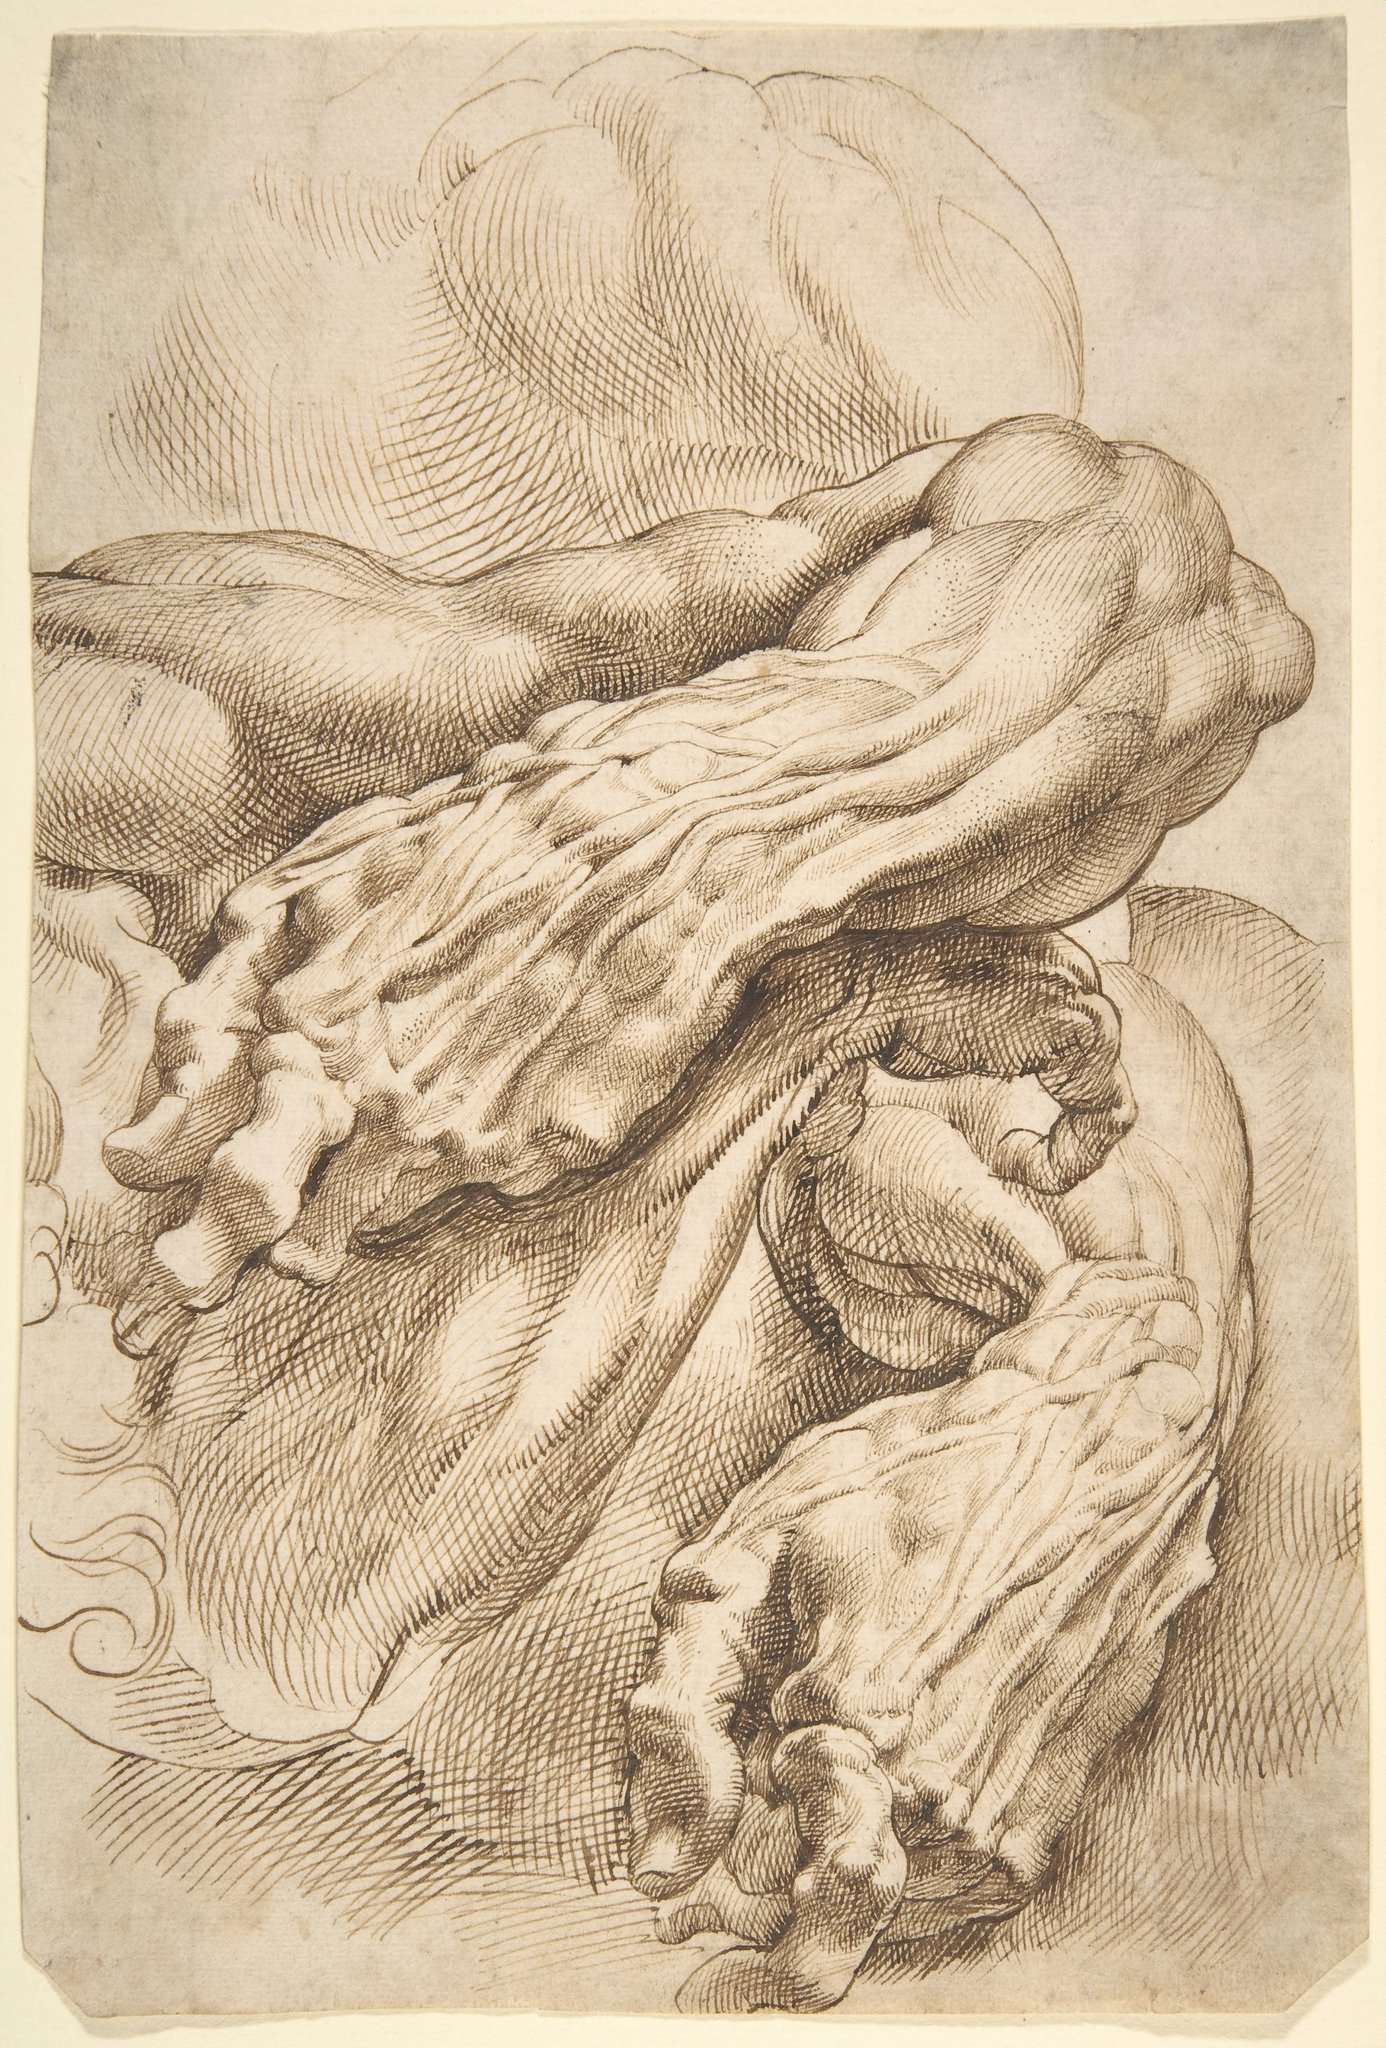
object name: drawing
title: Anatomical Studies: a left forearm in two positions and a right forearm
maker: peter paul rubens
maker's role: artist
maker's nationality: flemish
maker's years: 1577-1640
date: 1600-1605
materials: ink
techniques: pen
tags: hands